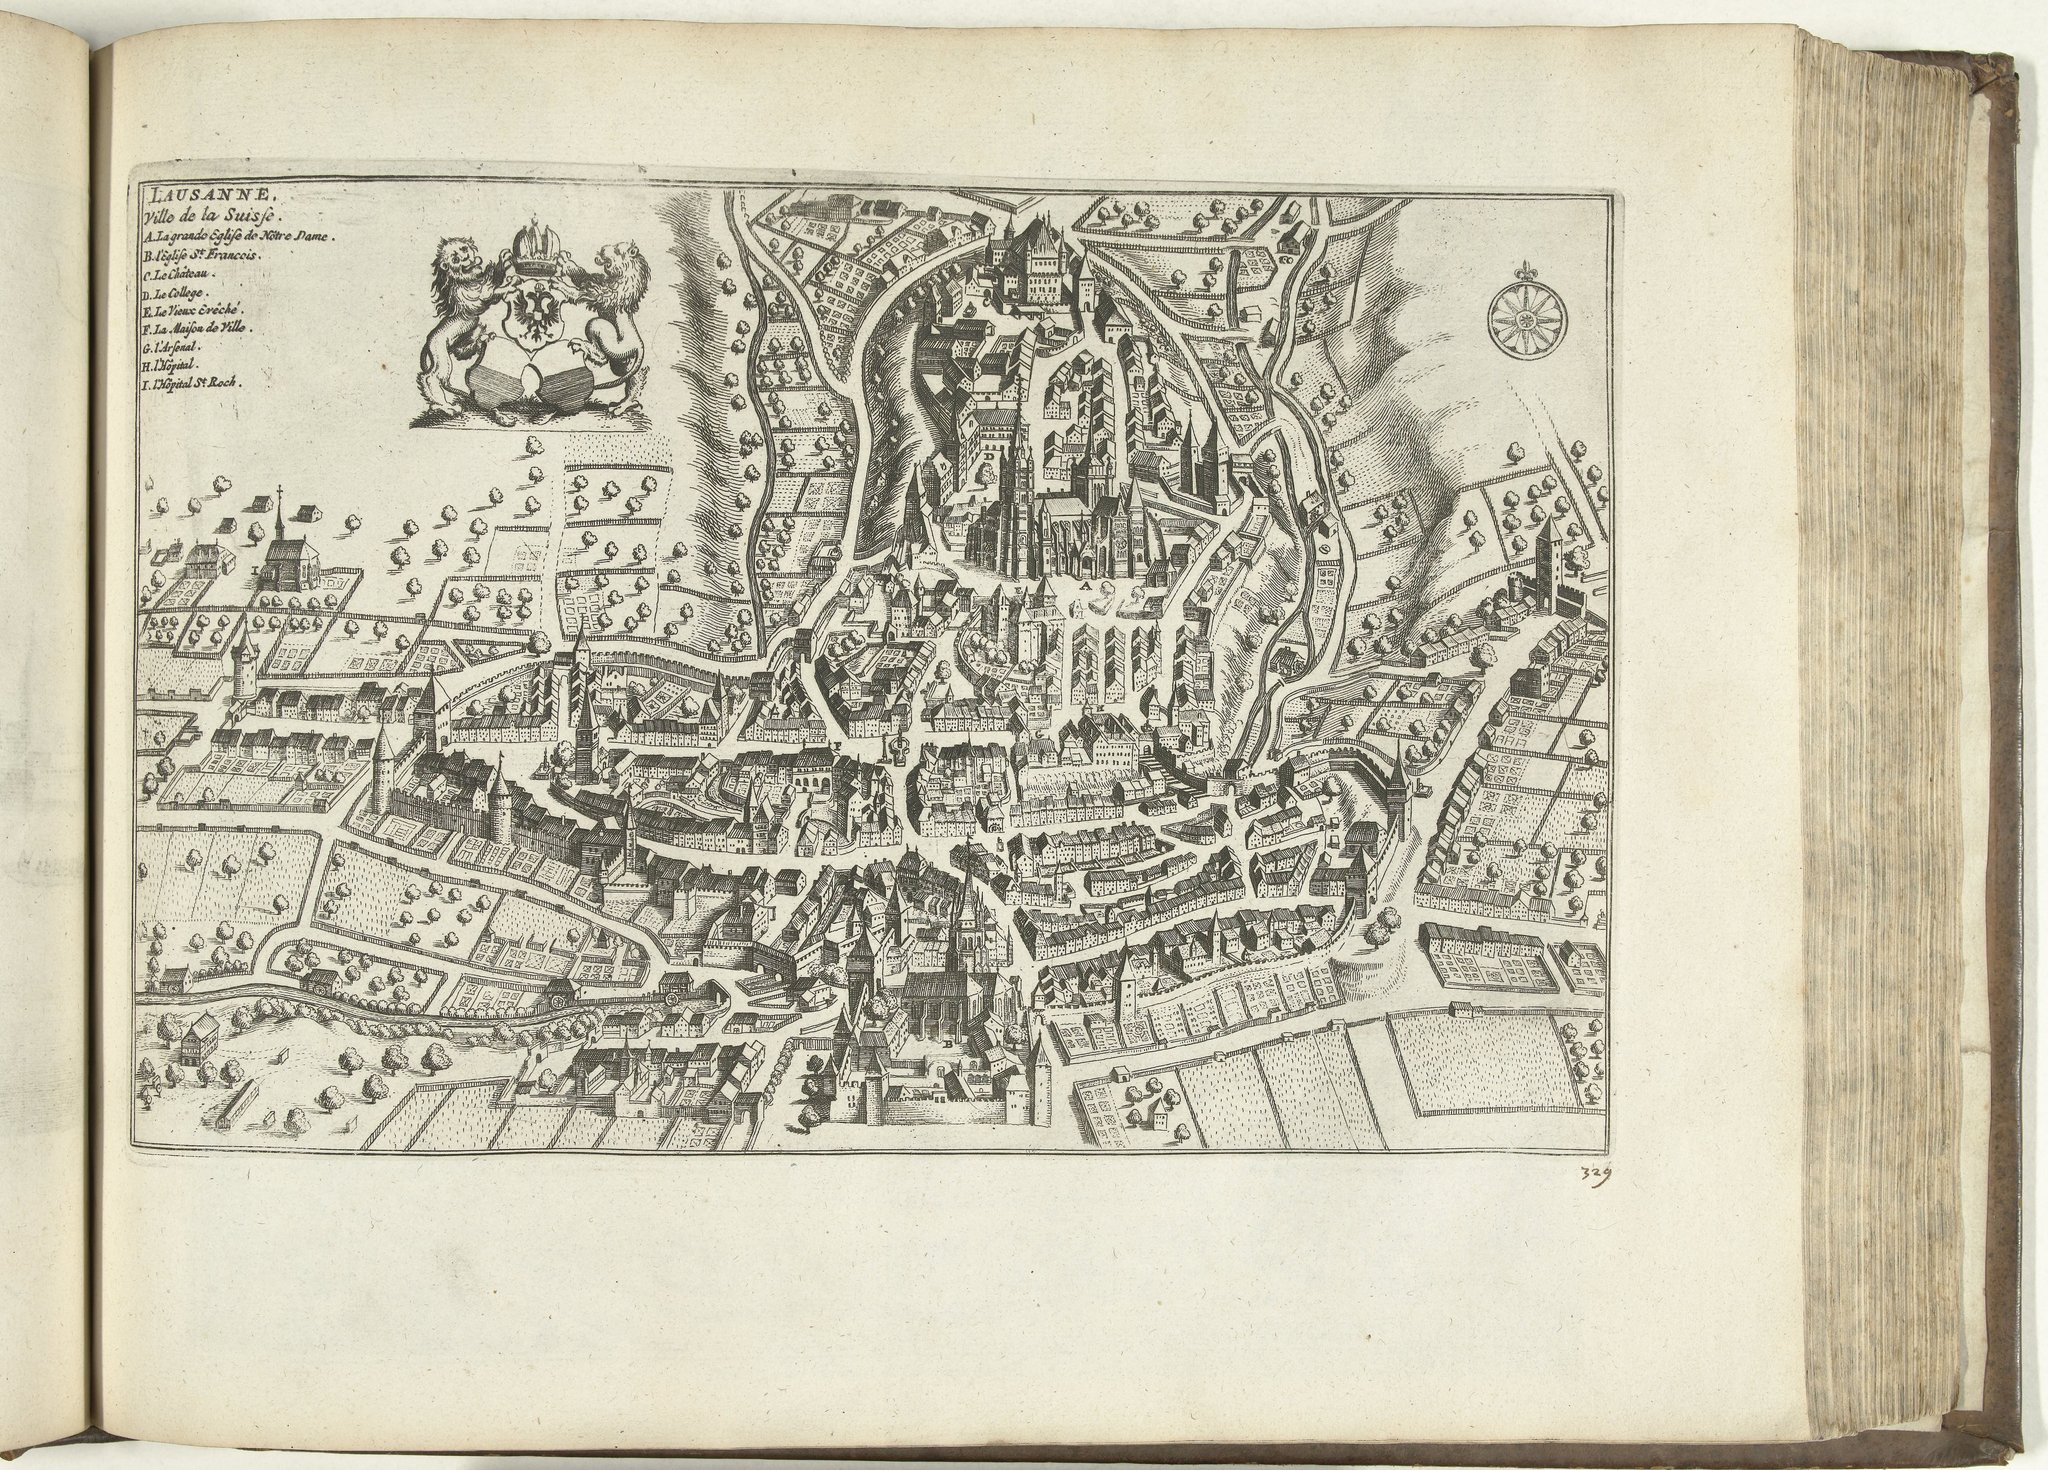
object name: print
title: Plattegrond van Lausanne, 1726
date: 1726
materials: paper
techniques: etching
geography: leiden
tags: maps of cities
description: Plattegrond van Lausanne. Plaat nr. 329 in deel XIV van het prentwerk: Les Forces de l'Europe, Asie, Afrique et Amerique ... Comme aussi les Cartes des Côtes de France et d'Espagne uit 1726, dit tweede deel met 271 met de hand genummerde platen van vermaarde sterke steden en vestingen in het kader van de Spaanse Successieoorlog 1701-1713. Voor het merendeel zijn deze platen gekopieerd naar de anonieme Franse platen van vermaarde sterke steden en vestingen: in Les forces de l'Europe en in: Le theatre de la guerre, dans les Pays-Bas, beide oorspronkelijk uitgegeven door Nicolas de Fer te Parijs (1693-1697) in het kader van de Negenjarige Oorlog. Titel en opschriften in het Frans.